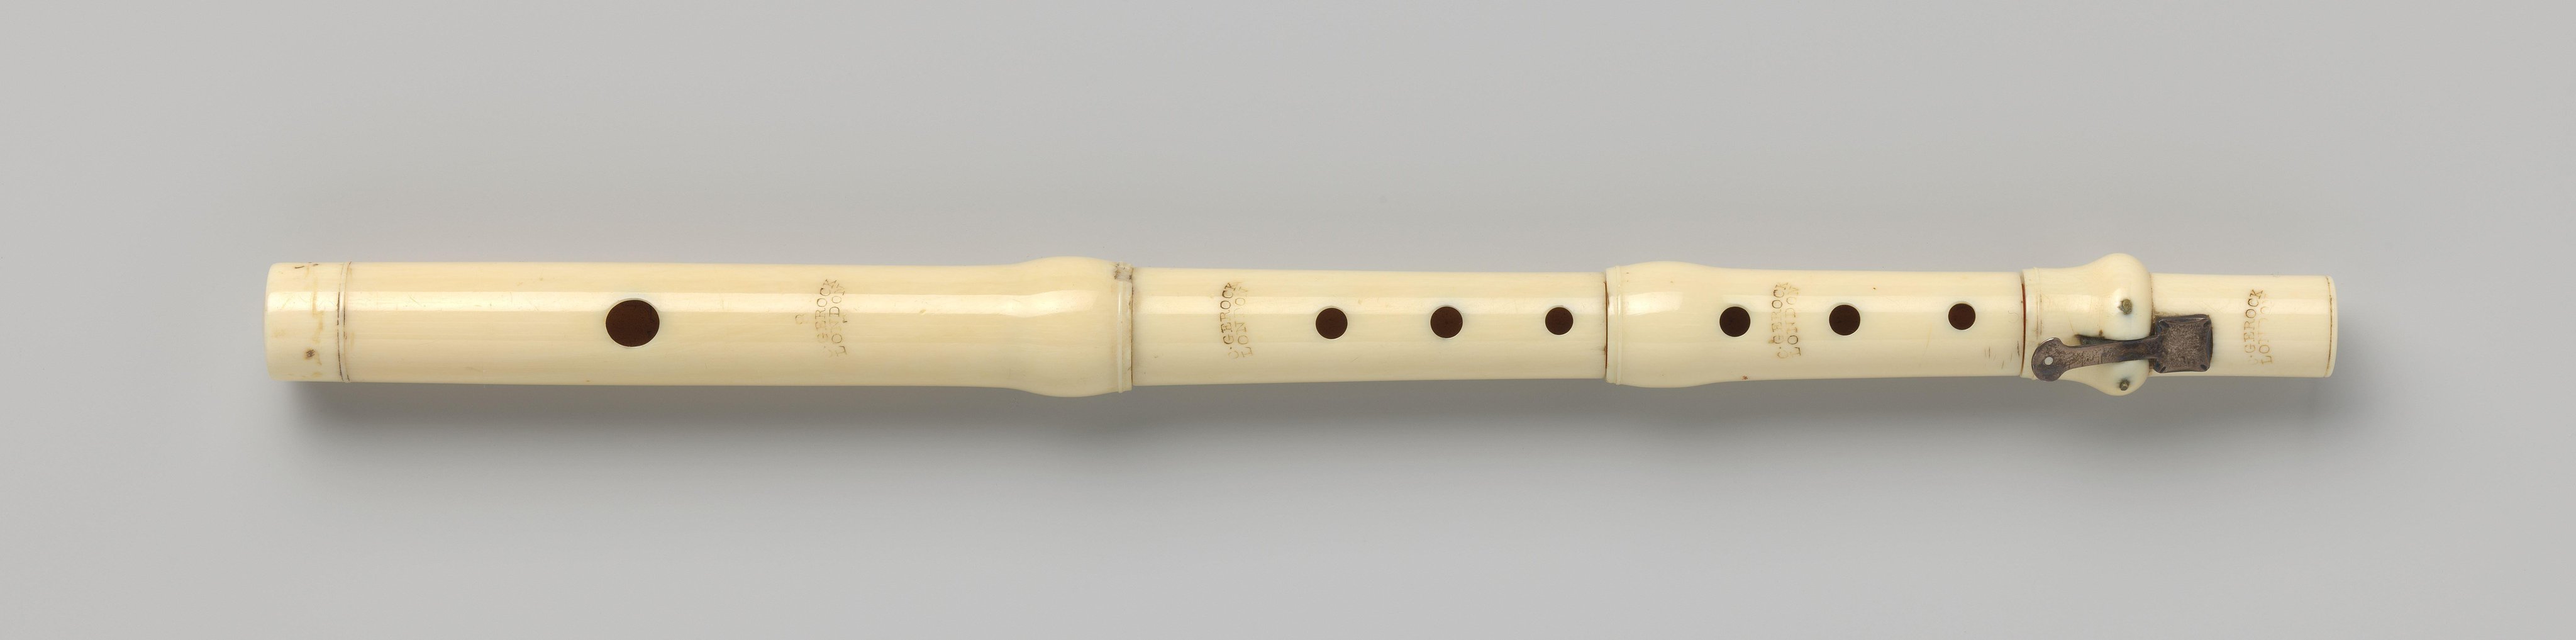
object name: piccolo flute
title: Piccolo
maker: christopher gerock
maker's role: musical instrument maker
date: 1815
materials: ivory, silver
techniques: casting, cutting, turning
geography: london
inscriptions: mark: ‘C. GEROCK / LONDON’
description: Piccolo bestaande uit vier onderdelen van ivoor met een zilveren klep. Inscripties staan op alle vier de onderdelen. Het topstuk heeft een extra inscriptie: 8.